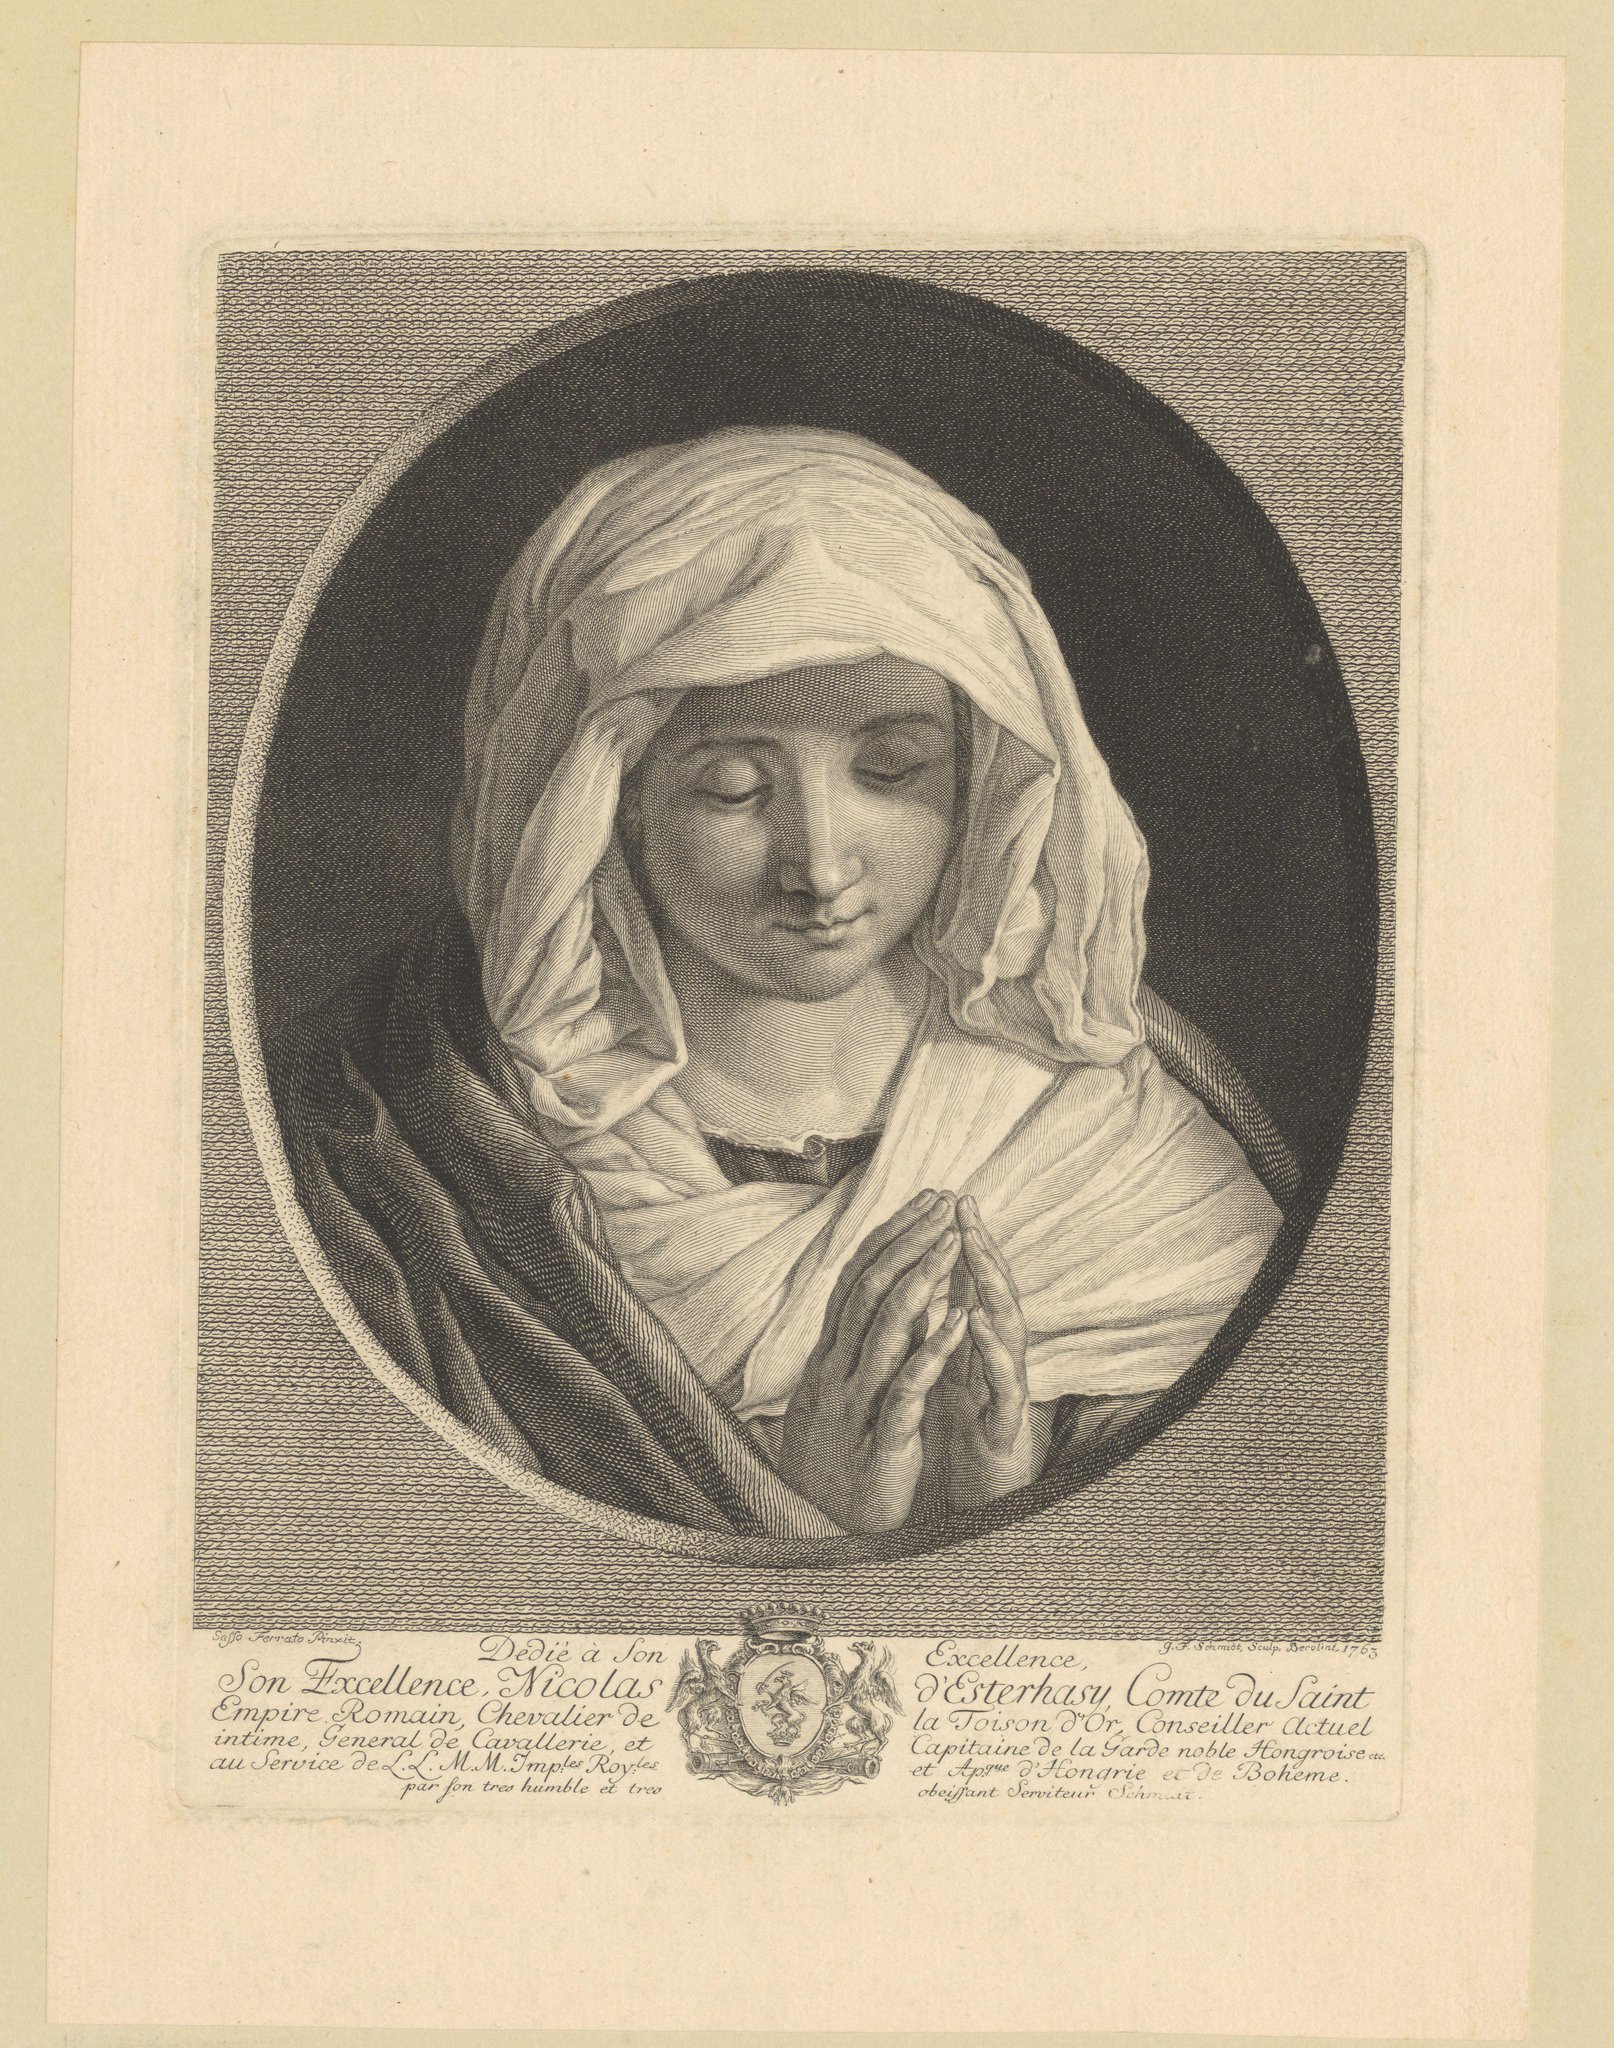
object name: print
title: Biddende Maria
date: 1763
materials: paper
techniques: engraving, etching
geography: berlin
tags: mary praying, armorial bearing, heraldry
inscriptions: collector's mark: Lugt 240